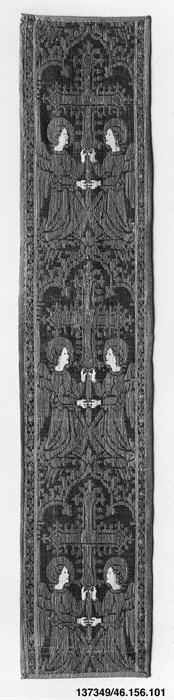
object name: orphrey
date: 1434-1466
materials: linen, metal thread, silk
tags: angels,cross